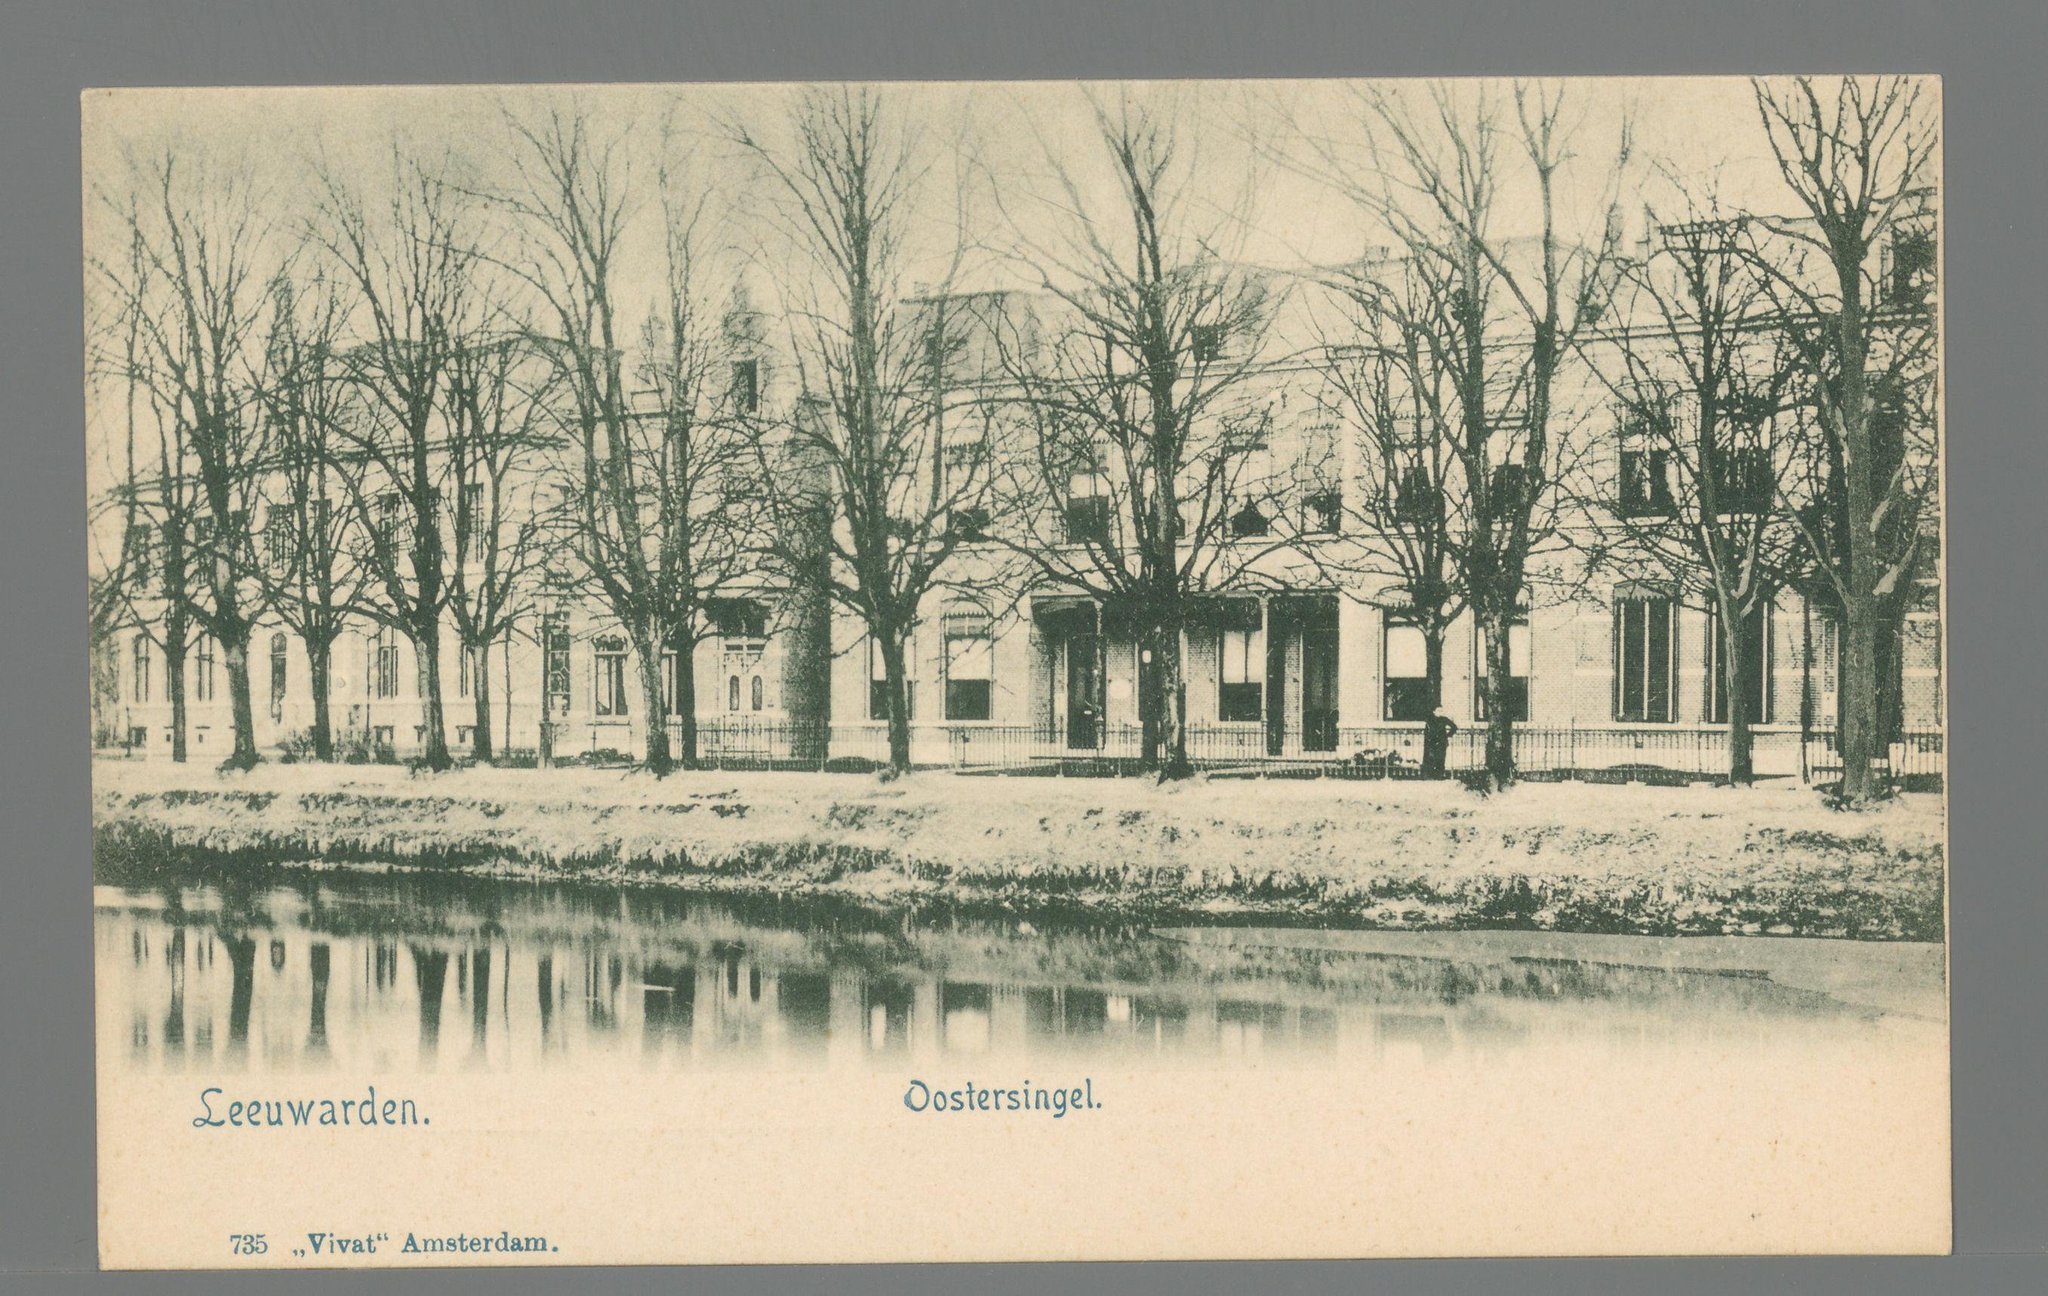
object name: ansichtkaart, prentbriefkaart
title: Leeuwarden. Oostersingel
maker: Anonymous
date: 1897-1905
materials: cardboard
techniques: photograph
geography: amsterdam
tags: trees, canal, street